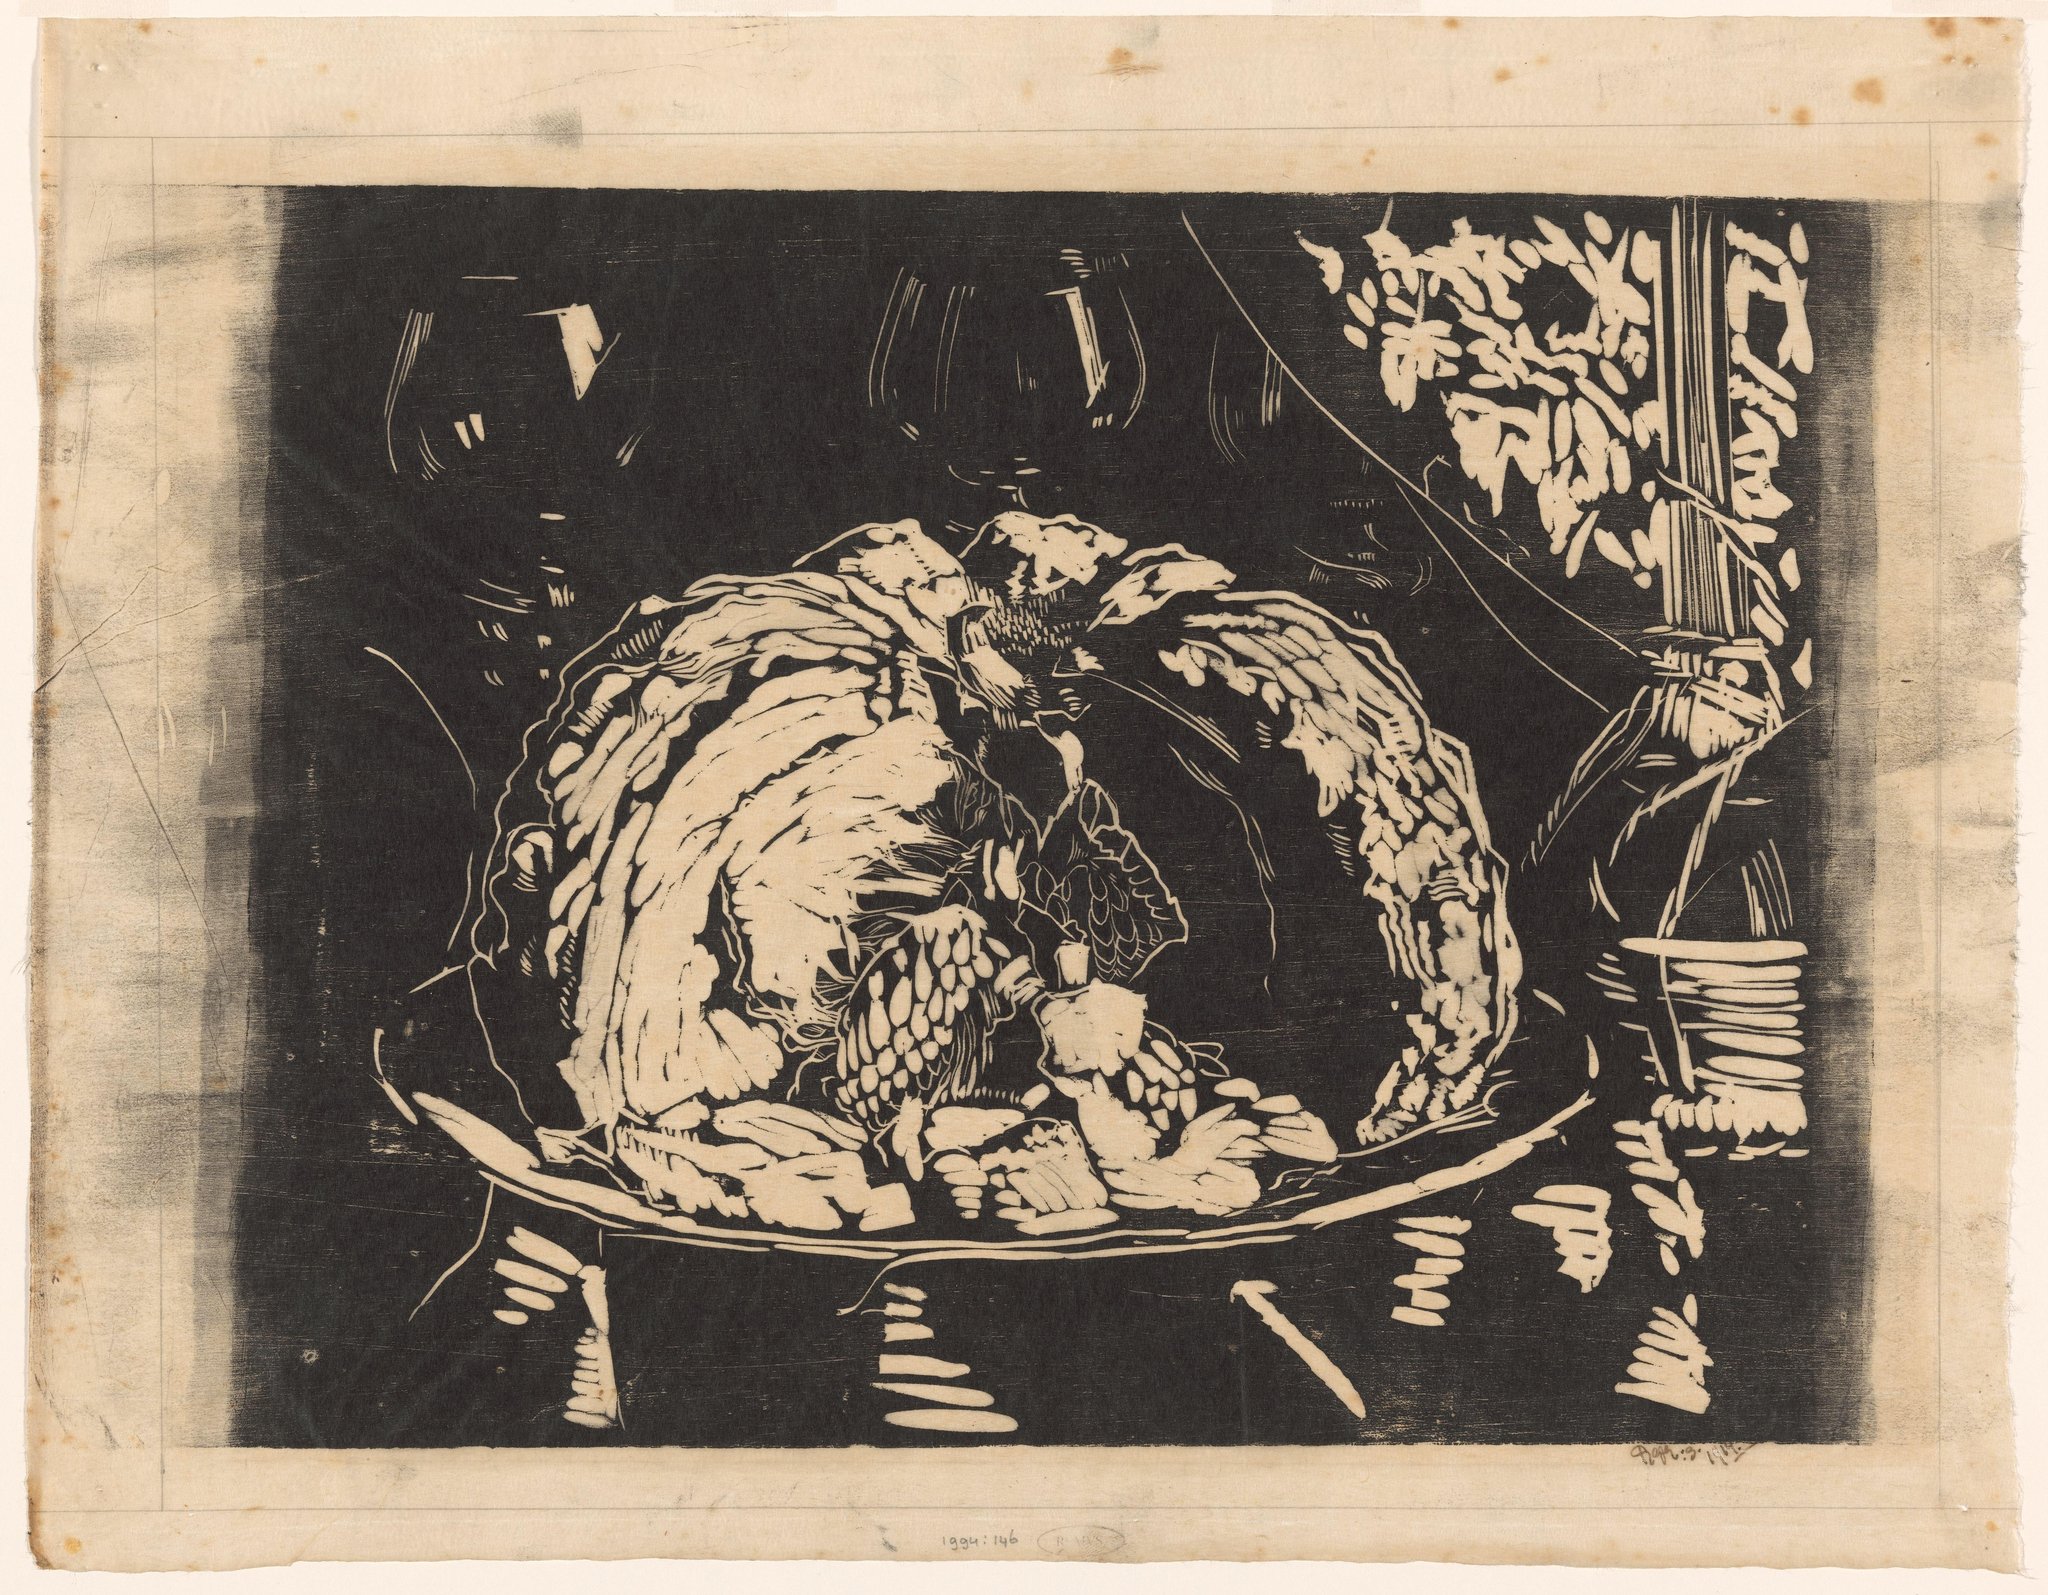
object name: print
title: Stilleven met schaal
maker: reijer stolk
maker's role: draughtsman, print maker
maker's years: 1896-1945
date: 1914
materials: paper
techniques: woodcut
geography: netherlands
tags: foodstuffs; still life of foodstuffs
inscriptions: collector's mark: Lugt 2228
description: Stilleven met wijnglazen en een schaal met daarop voedsel, mogelijk een brood of een pompoen.